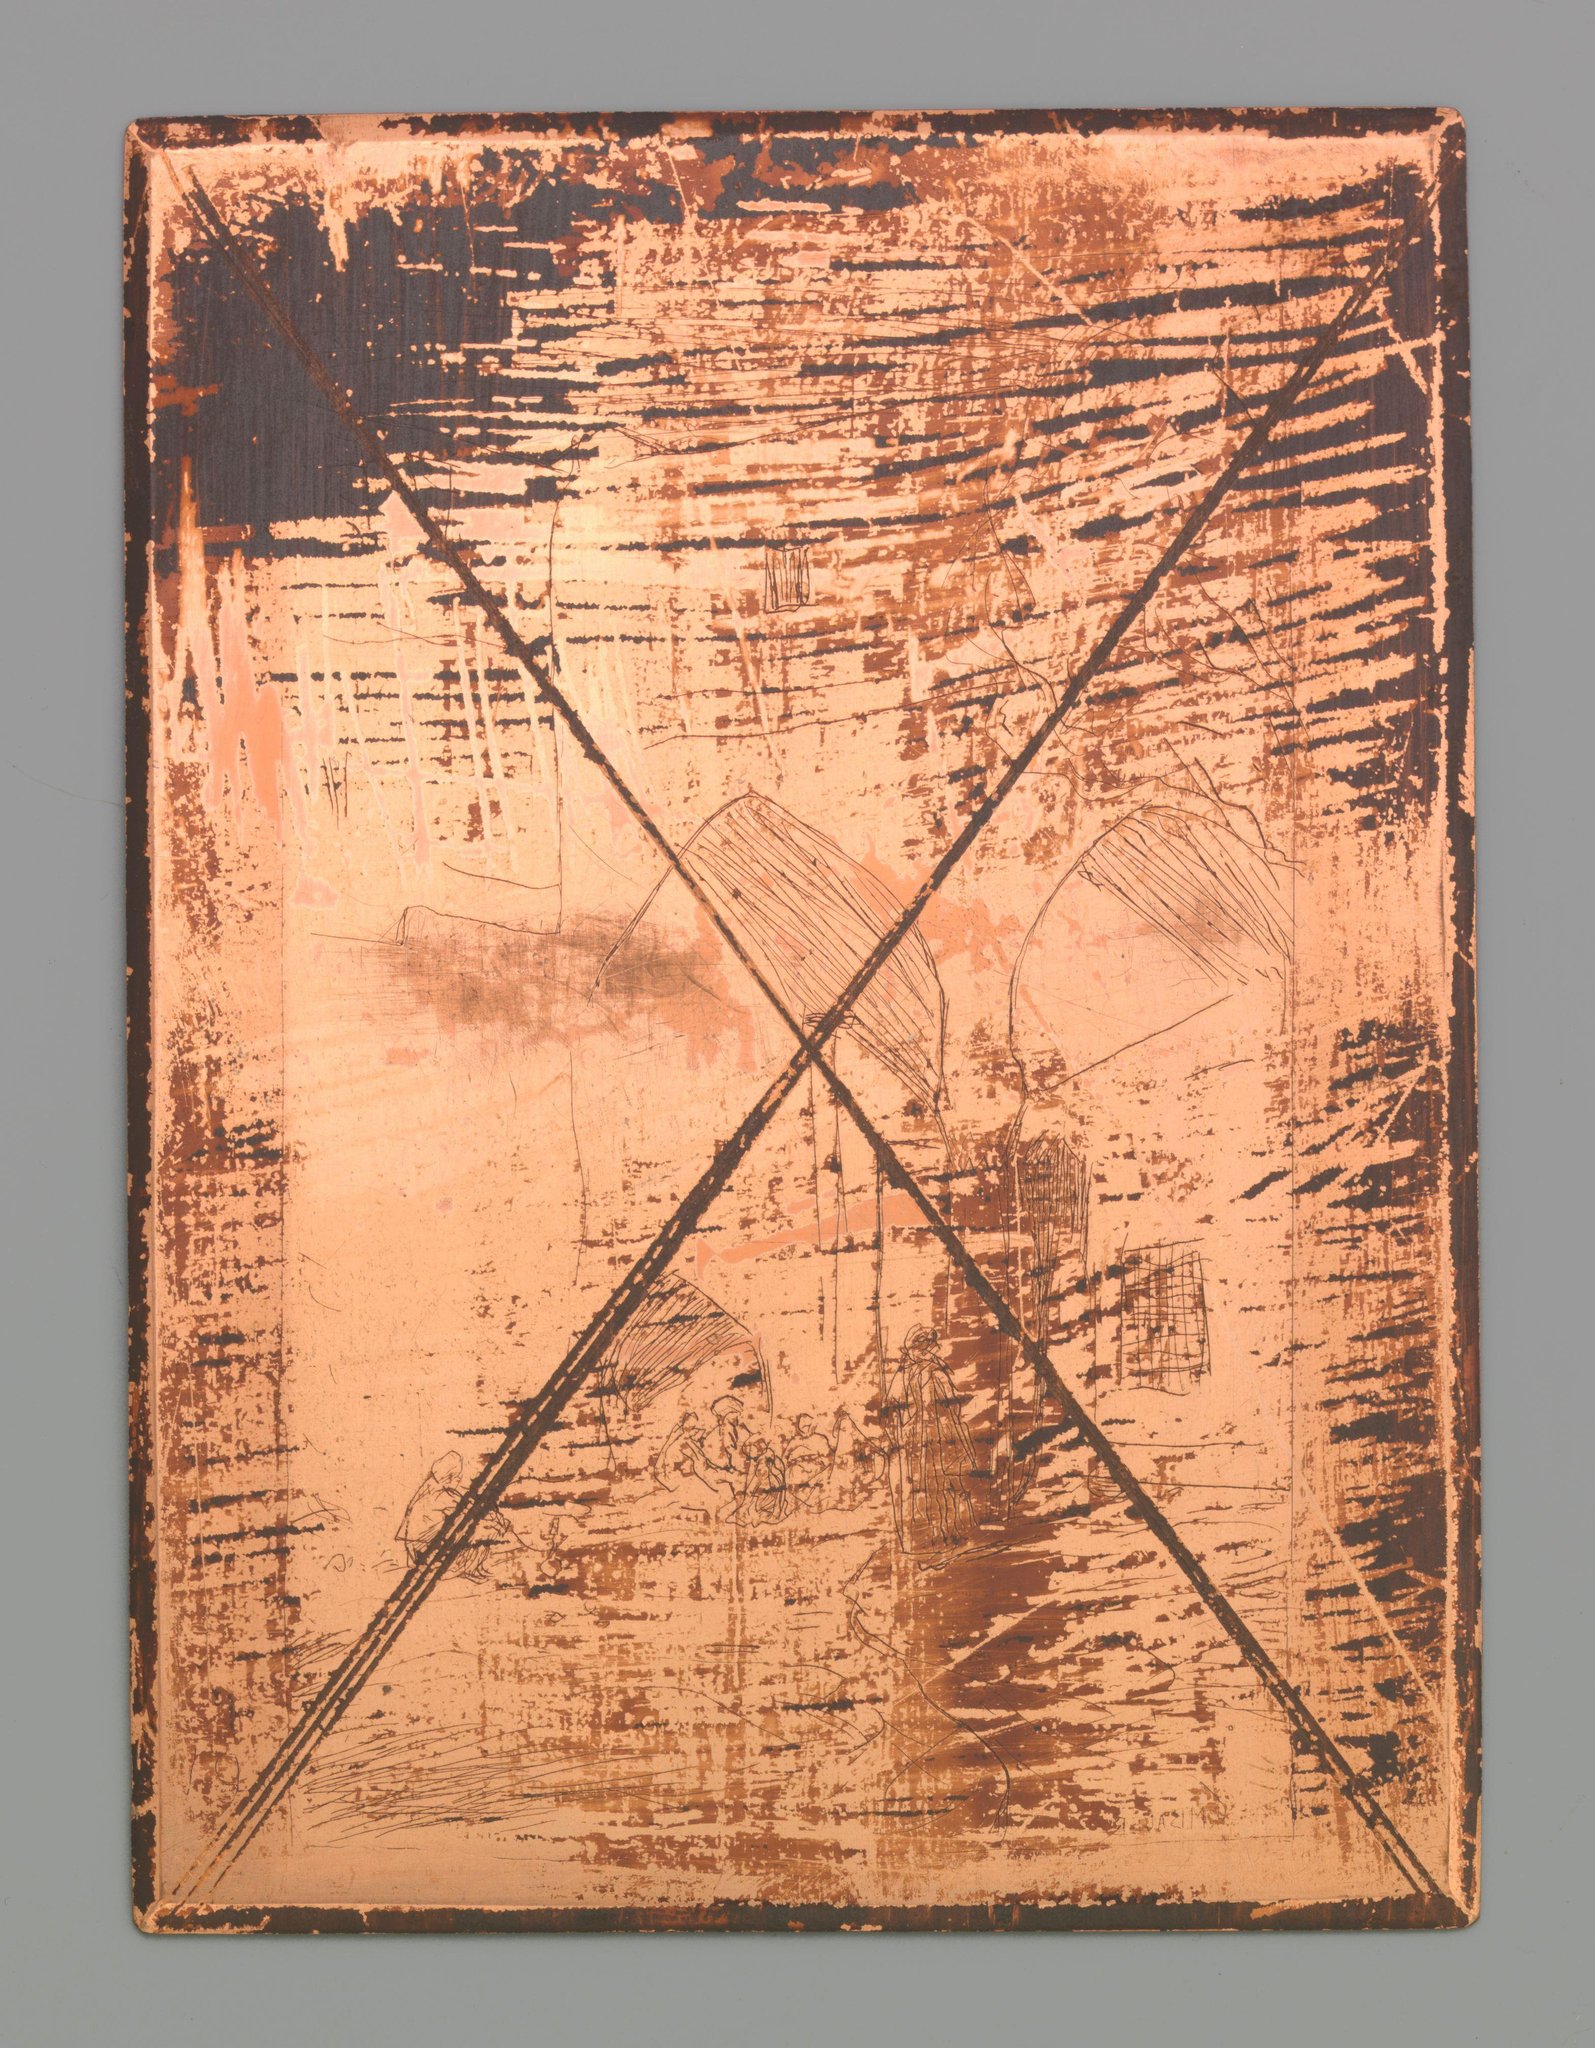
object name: copper plate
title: De moskee, Scutari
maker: marius bauer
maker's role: draughtsman, print maker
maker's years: 1867-1932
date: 1924-1932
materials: copper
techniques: etching